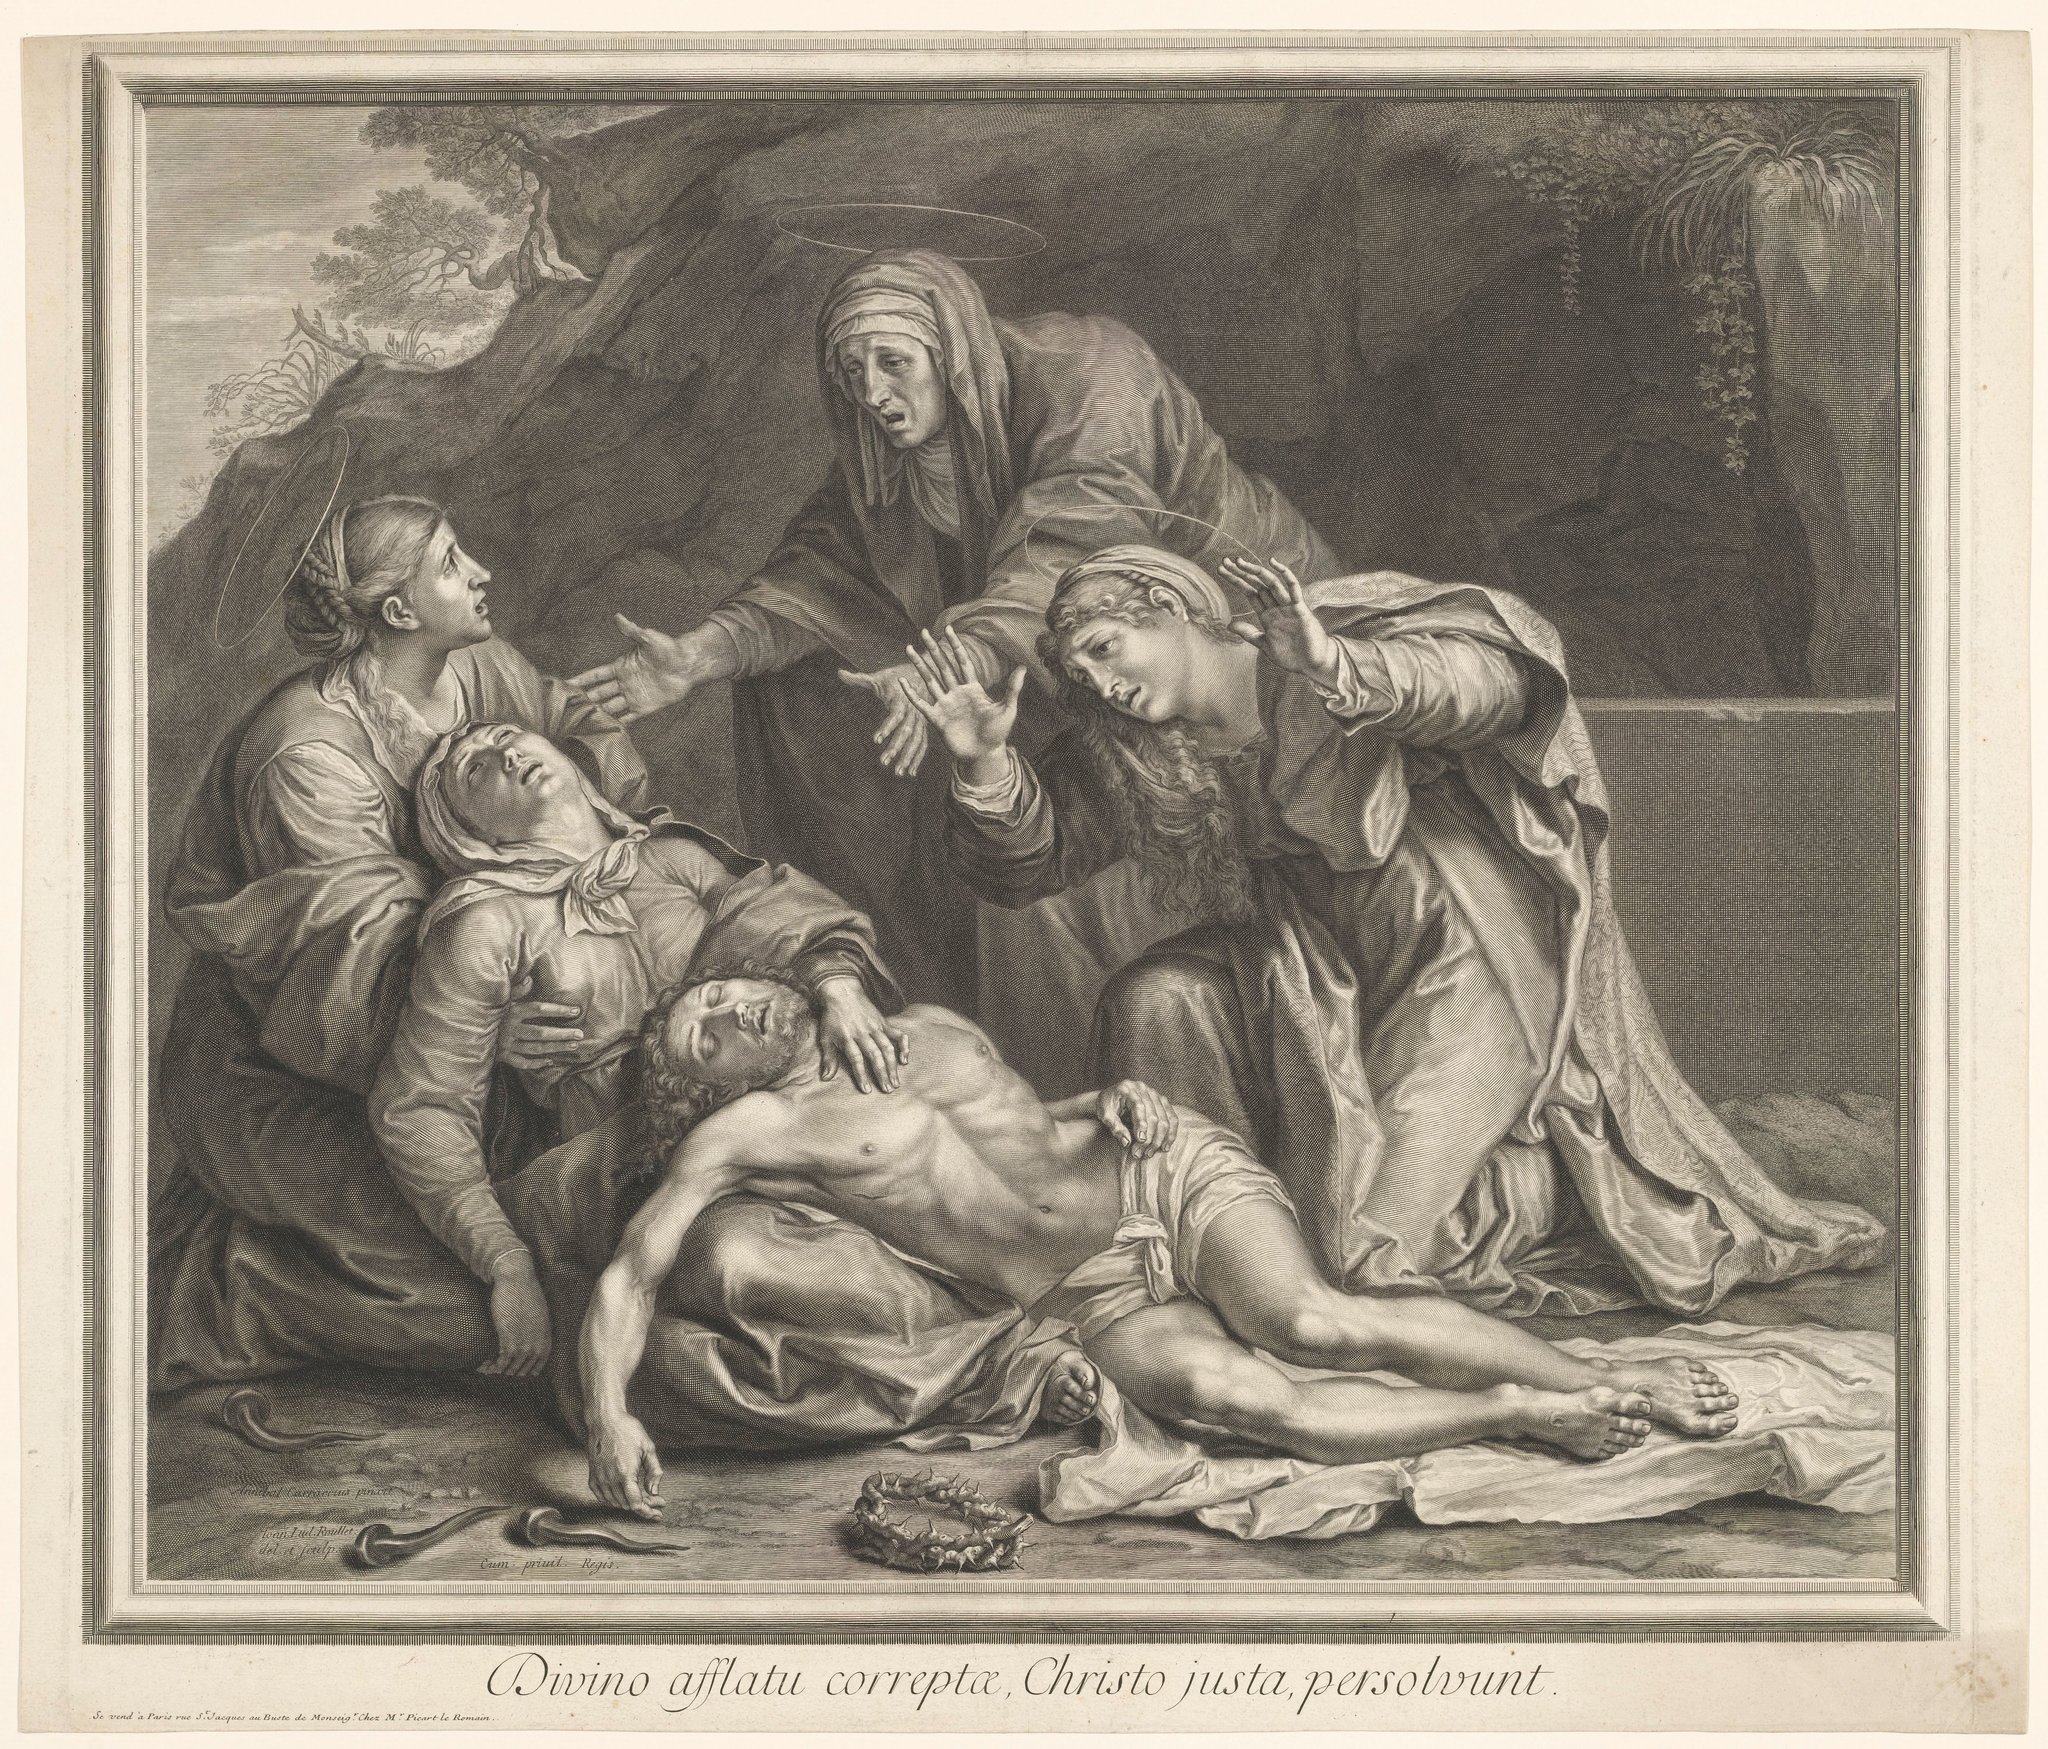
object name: print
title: Bewening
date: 1655-1699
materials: paper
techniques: engraving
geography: france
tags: lamentation over the dead christ by his relatives and friends (christ usually without crown of thorns)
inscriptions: collector's mark: Lugt 240